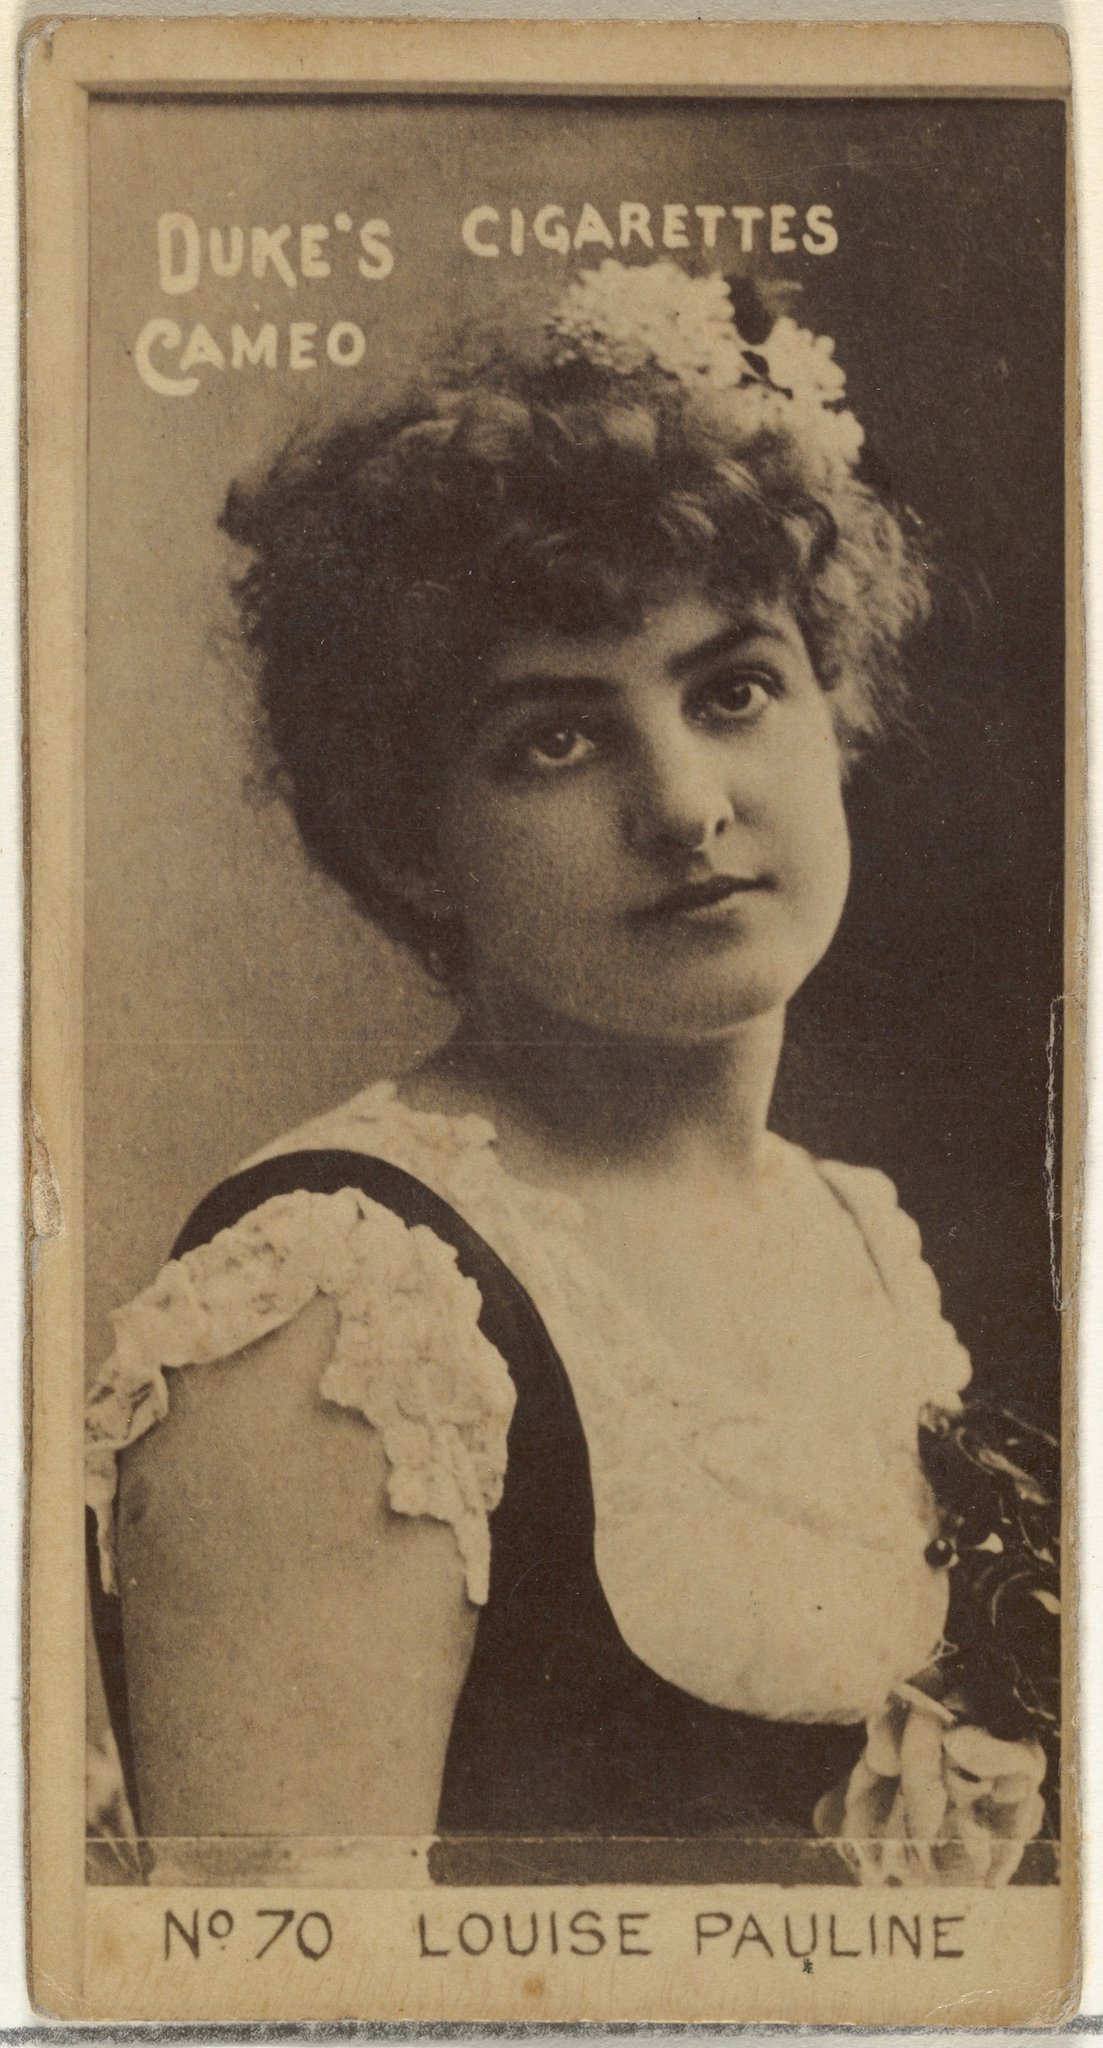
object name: photograph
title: Card Number 70, Louise Pauline, from the Actors and Actresses series (N145-4) issued by Duke Sons & Co. to promote Cameo Cigarettes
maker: w. duke, sons & co.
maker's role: publisher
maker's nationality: american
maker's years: 1870-1920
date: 1880-1889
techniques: albumen silver print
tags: portraits,women,actresses